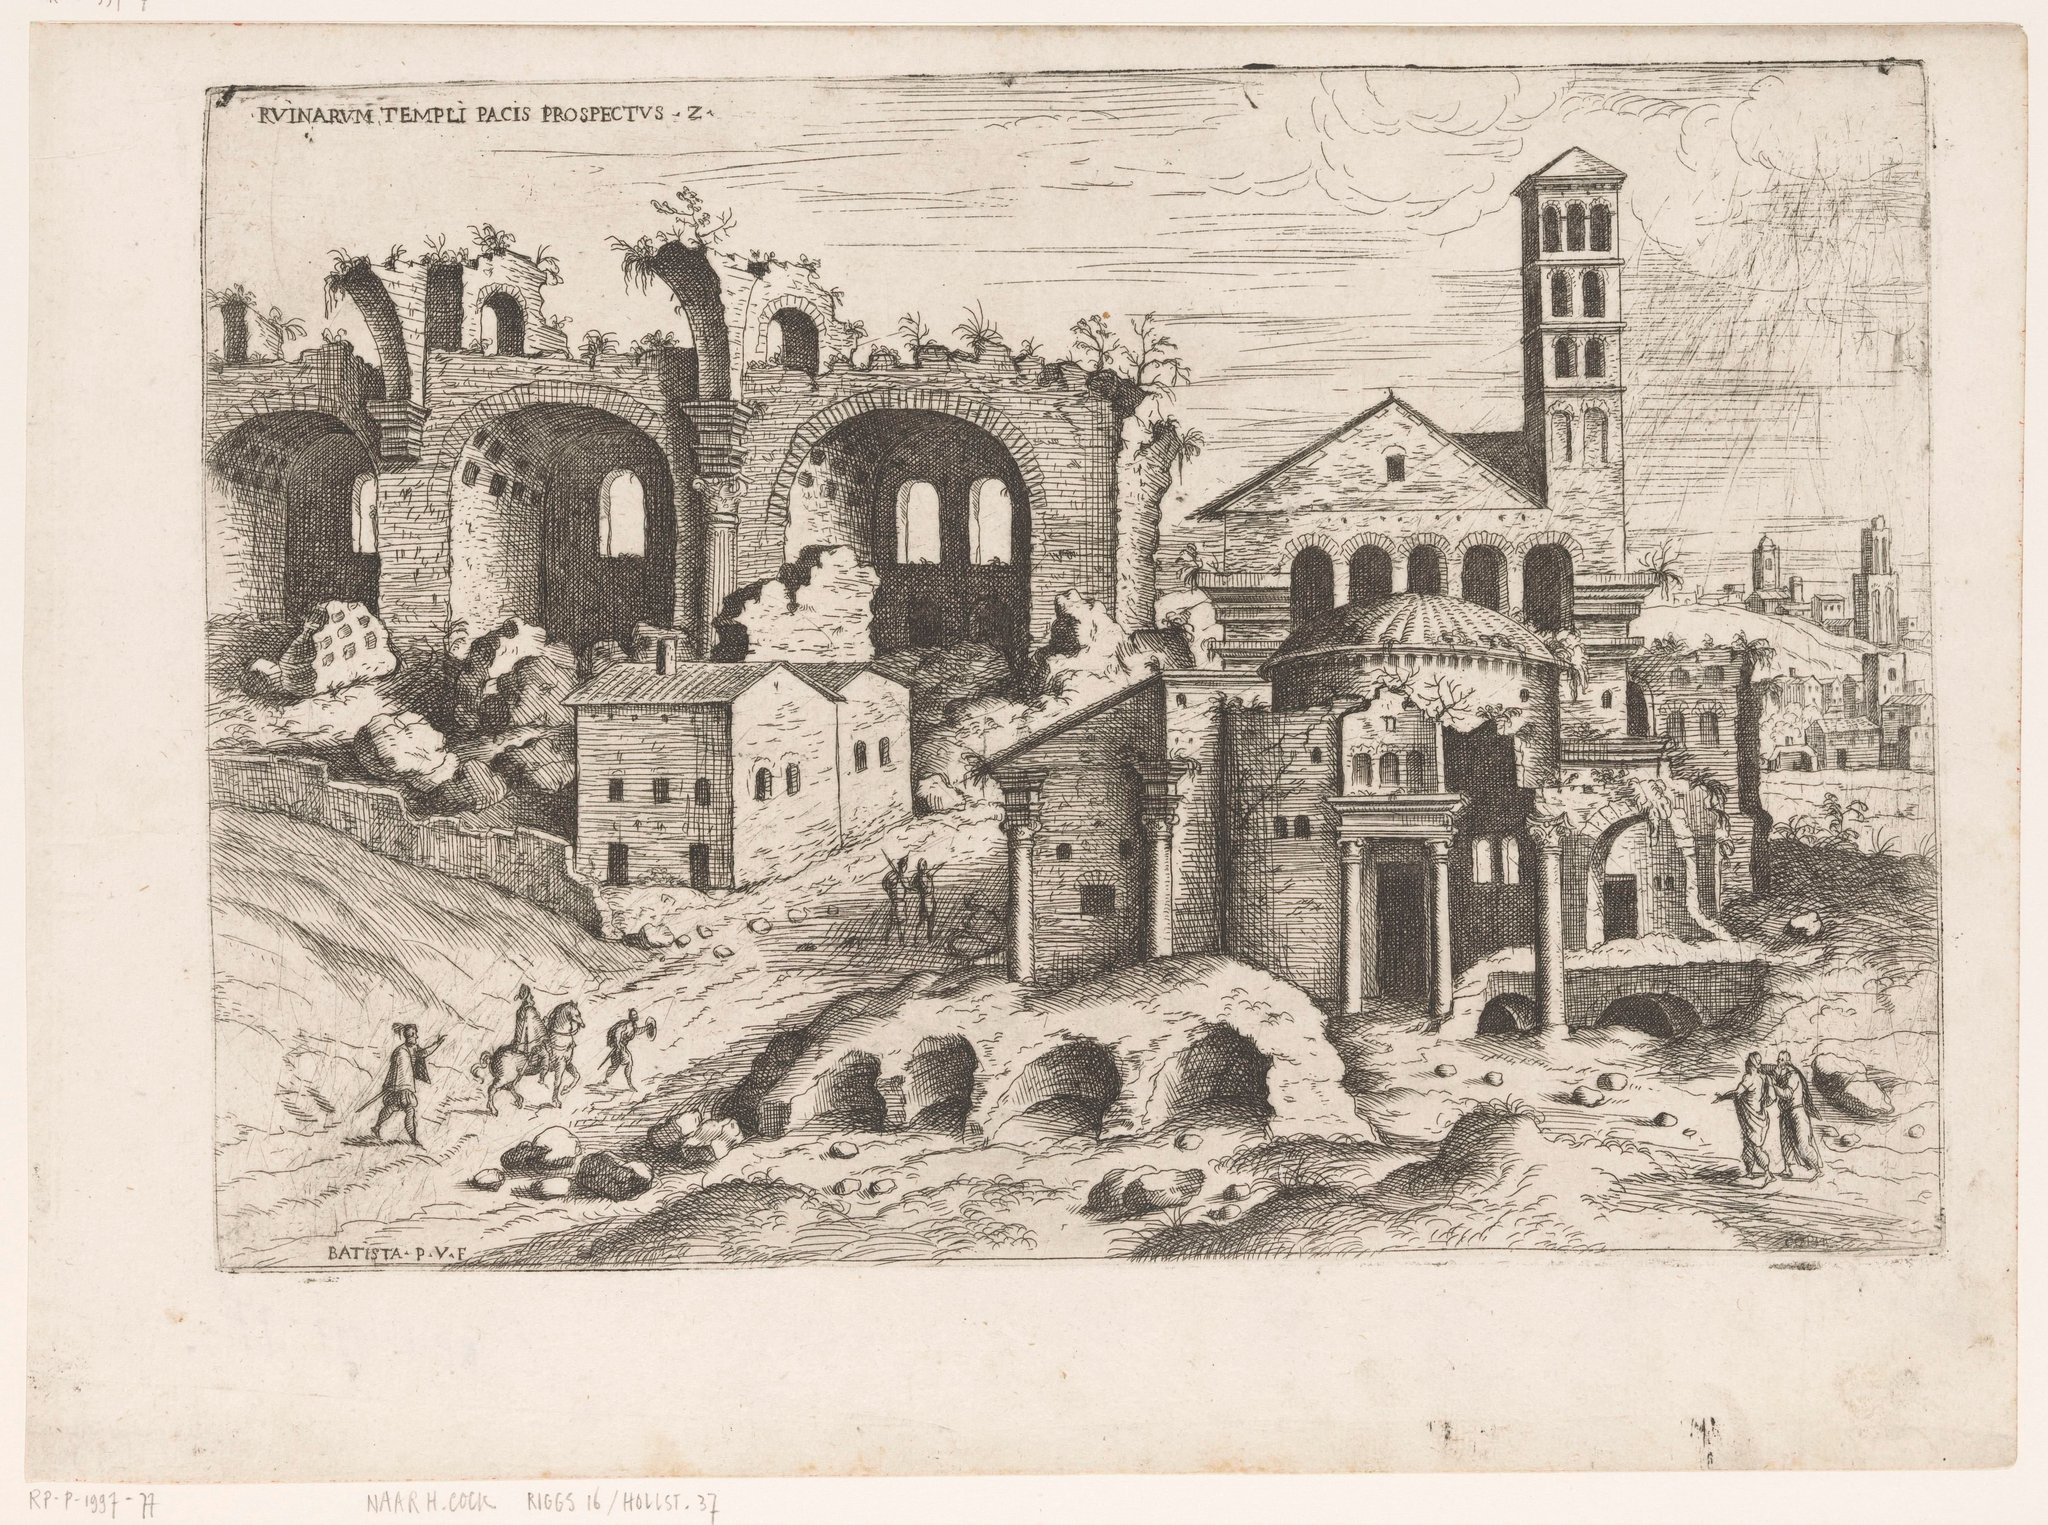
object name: print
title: Romeinse ruïnes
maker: giovanni battista pittoni (i)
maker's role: print maker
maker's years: 1520-1583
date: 1561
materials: paper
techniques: etching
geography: vicenza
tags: ruin of a building ~ architecture, landscape with ruins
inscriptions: collector's mark: Lugt 2228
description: Deze prent maakt deel uit van een reeks illustraties voor het traktaat van Vincenzo Scamozzi 'Discorsi sopra le antichità di Roma', Venetië 1582. De prenten zijn vrije kopieën naar een serie prenten van Hieronymus Cocks die voor het eerst werd uitgegeven in 1551 (Hollstein 22-47).